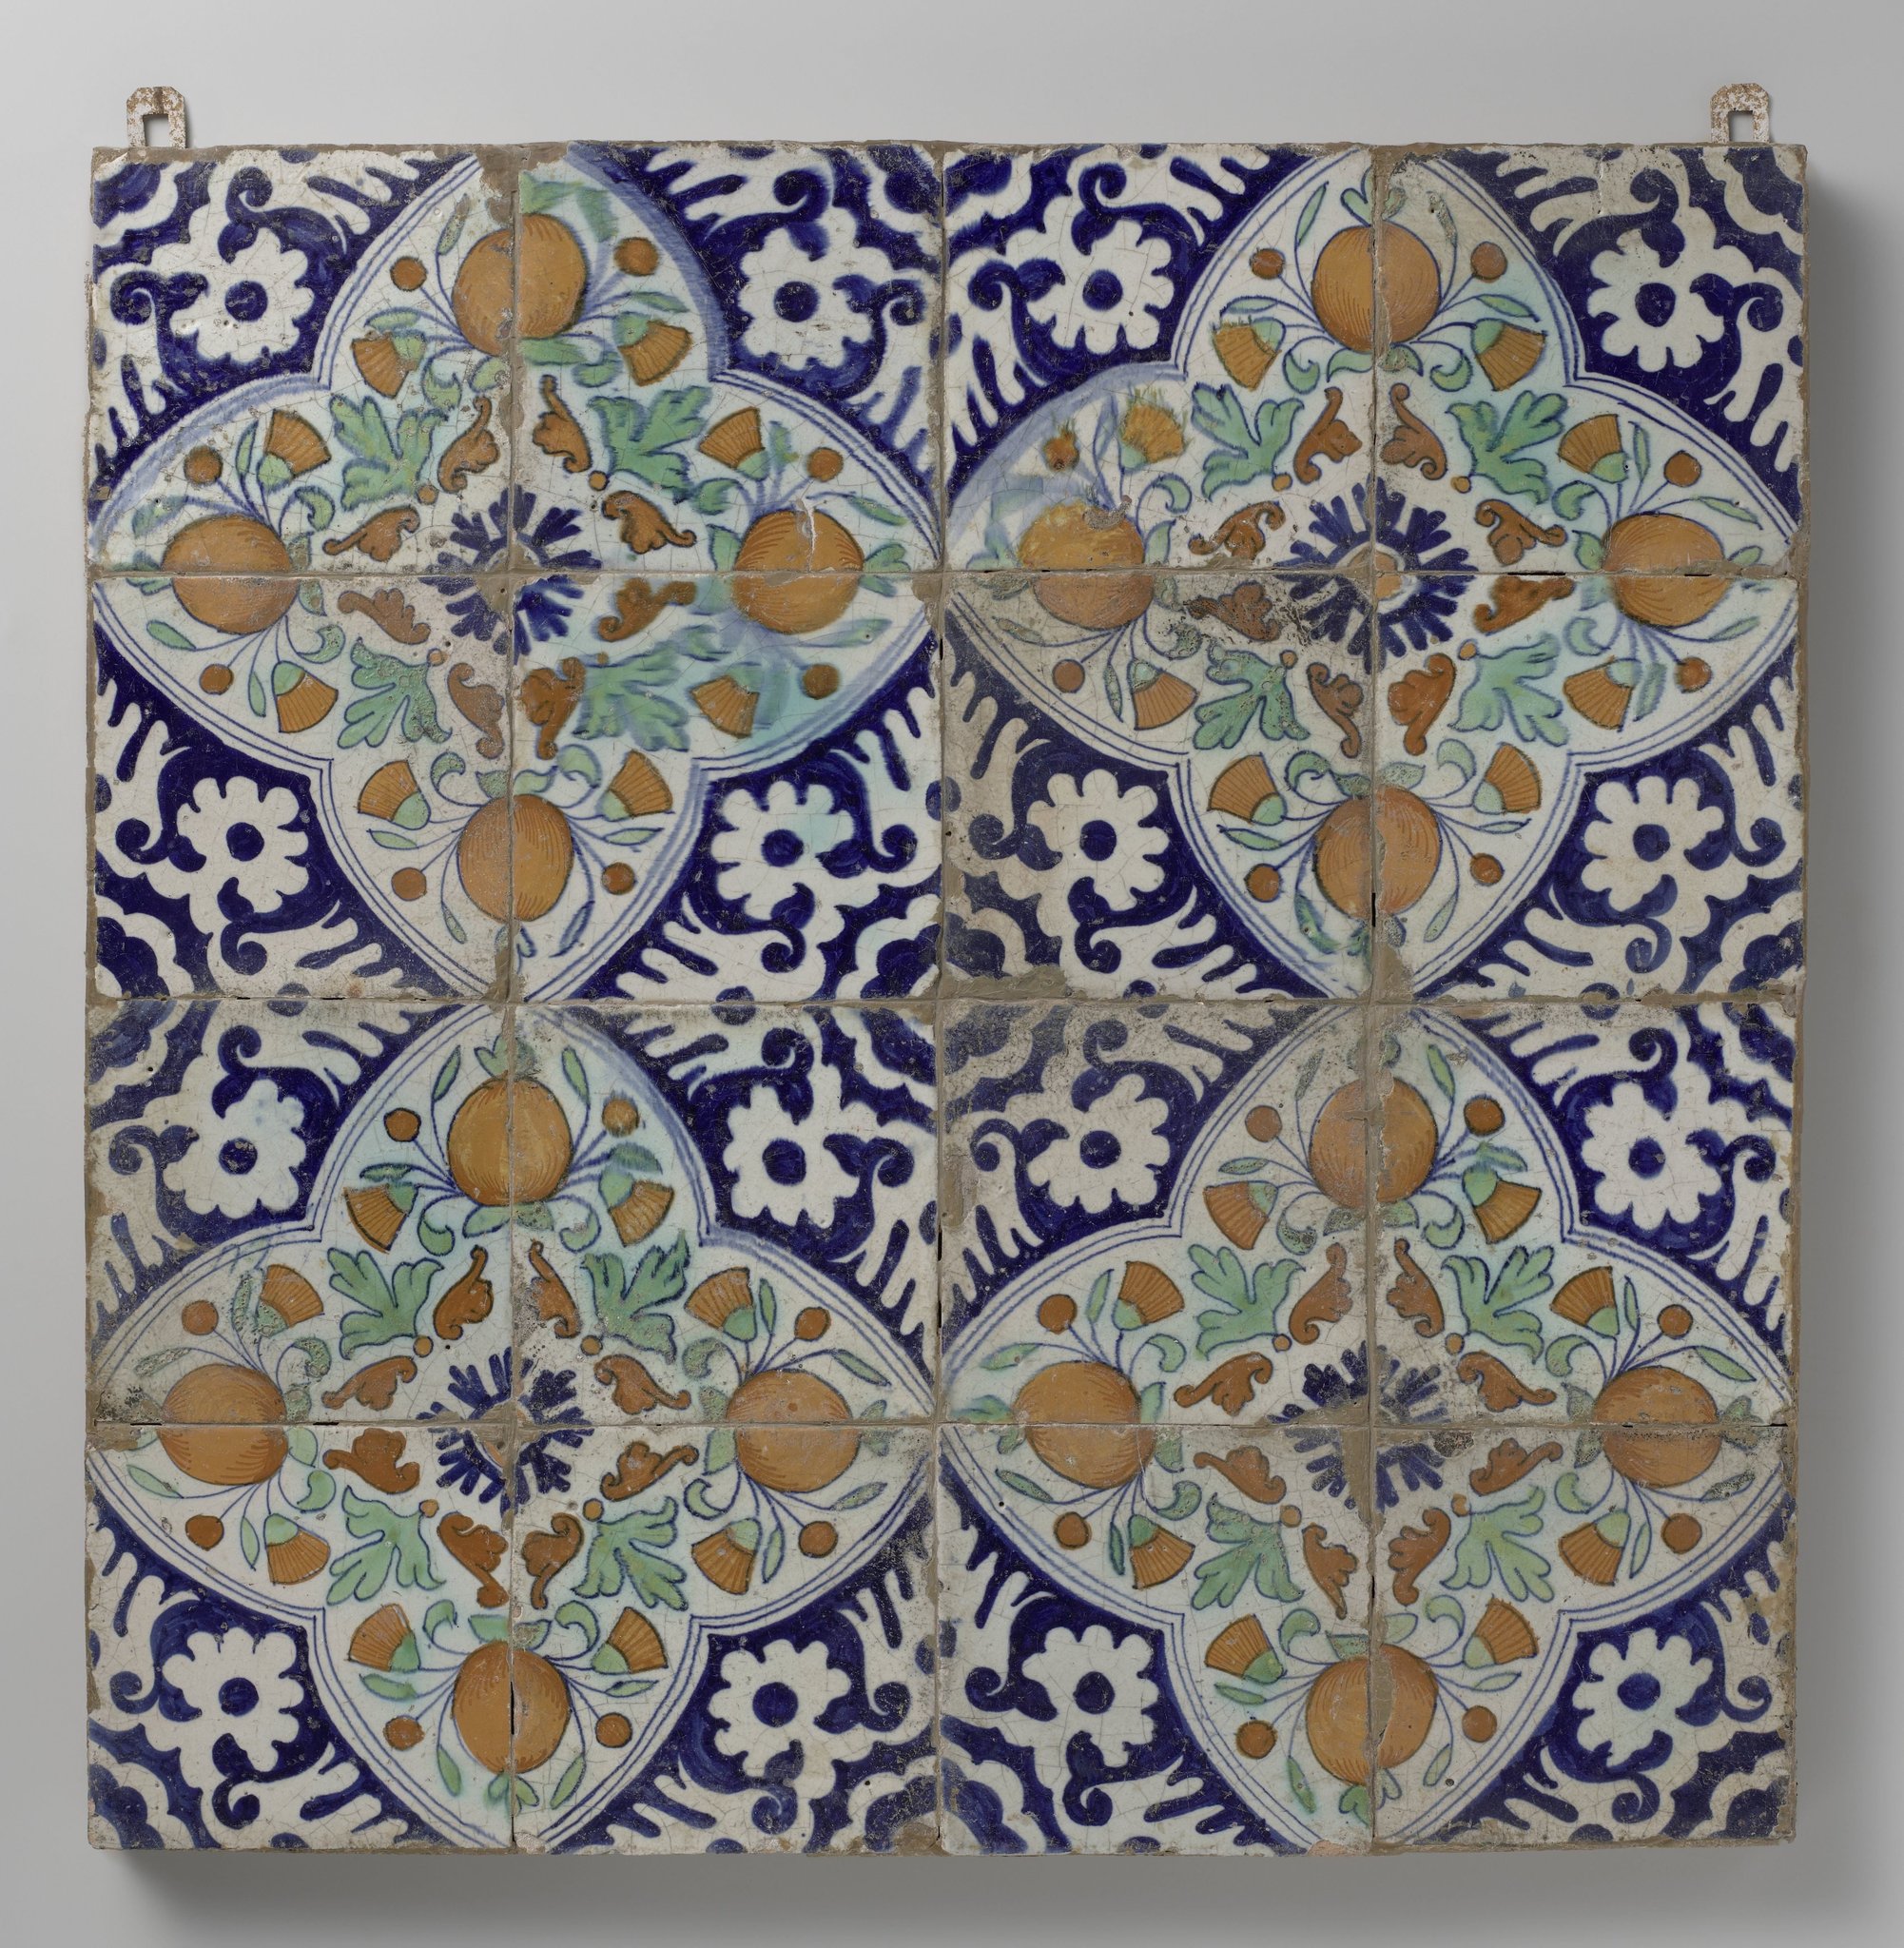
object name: vierpastegel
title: Veld van zestien tegels met granaatappels en goudsbloemen in vier vierpassen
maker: Anonymous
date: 1580-1620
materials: earthenware, glaze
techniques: maiolica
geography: netherlands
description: Veld van zestien tegels (4 x 4) met veelkleurig (blauw, oranje, groen en geel) geschilderde granaatappels en goudsbloemen binnen een vierpas, gevormd uit vier tegels. De vierpassen zijn omgeven door ornament in vultechniek.